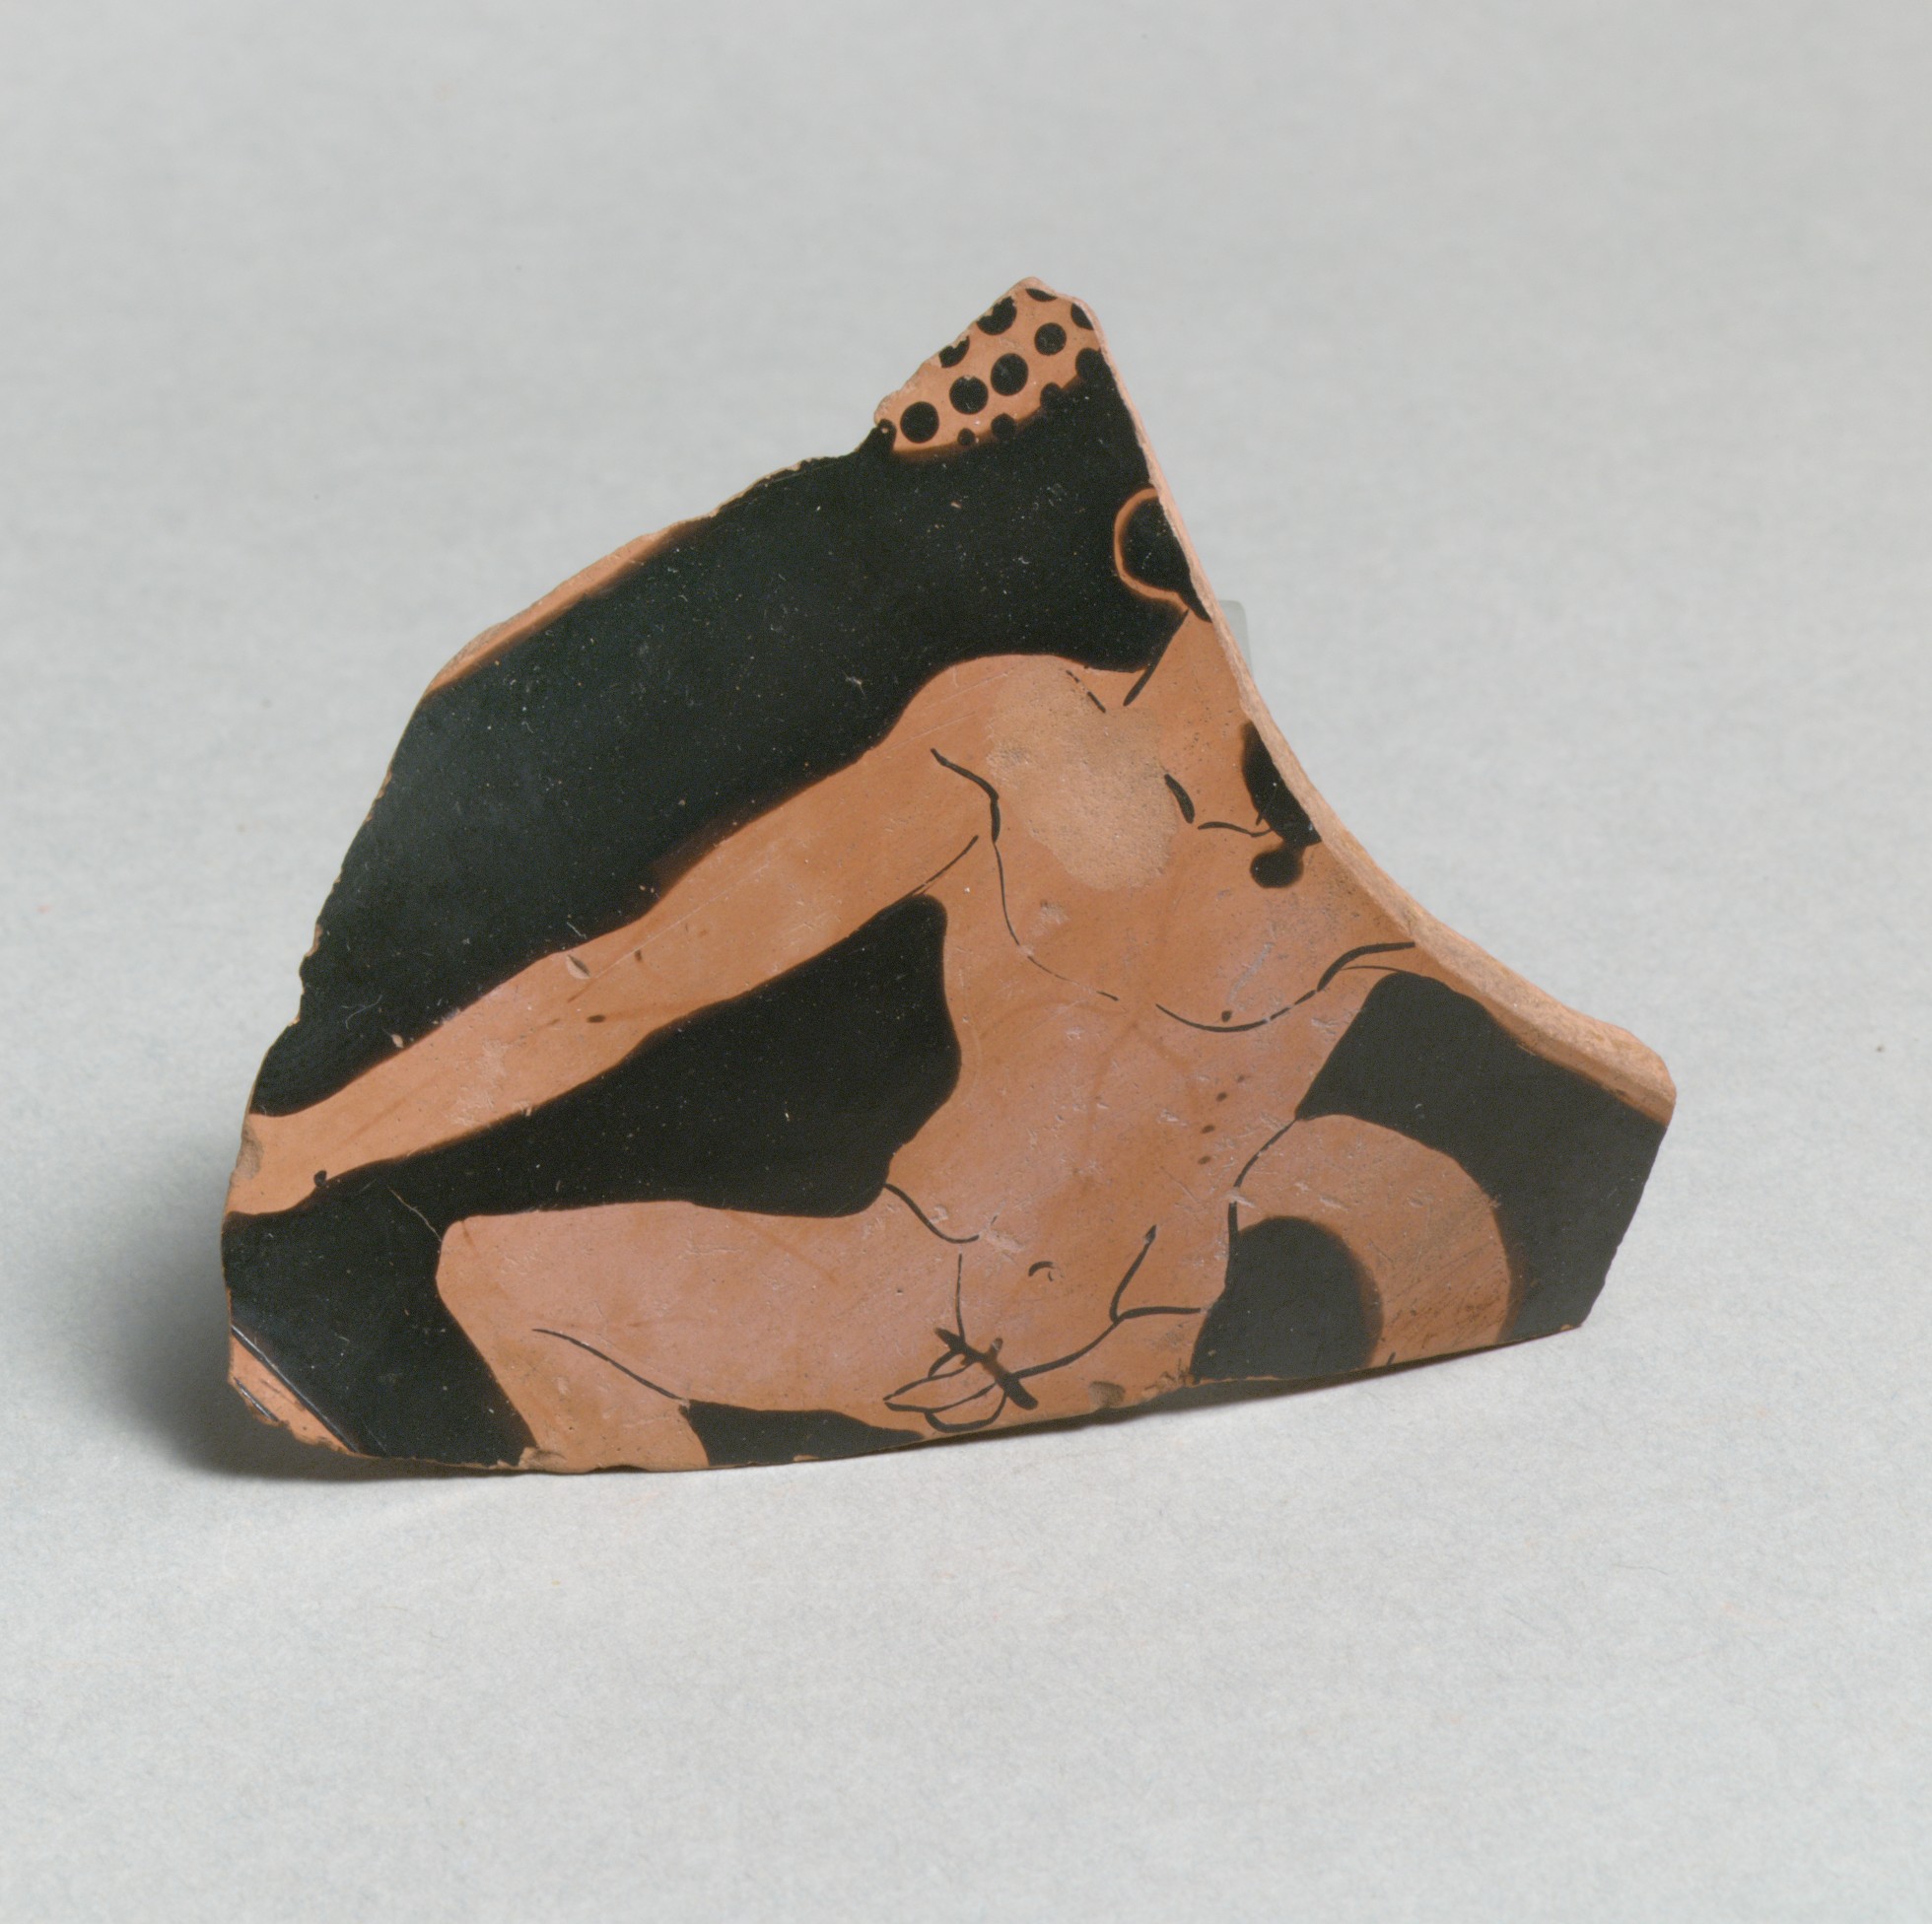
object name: rhyton fragment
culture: greek, attic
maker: sotades painter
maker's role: artist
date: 450-400 BCE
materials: terracotta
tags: male nudes